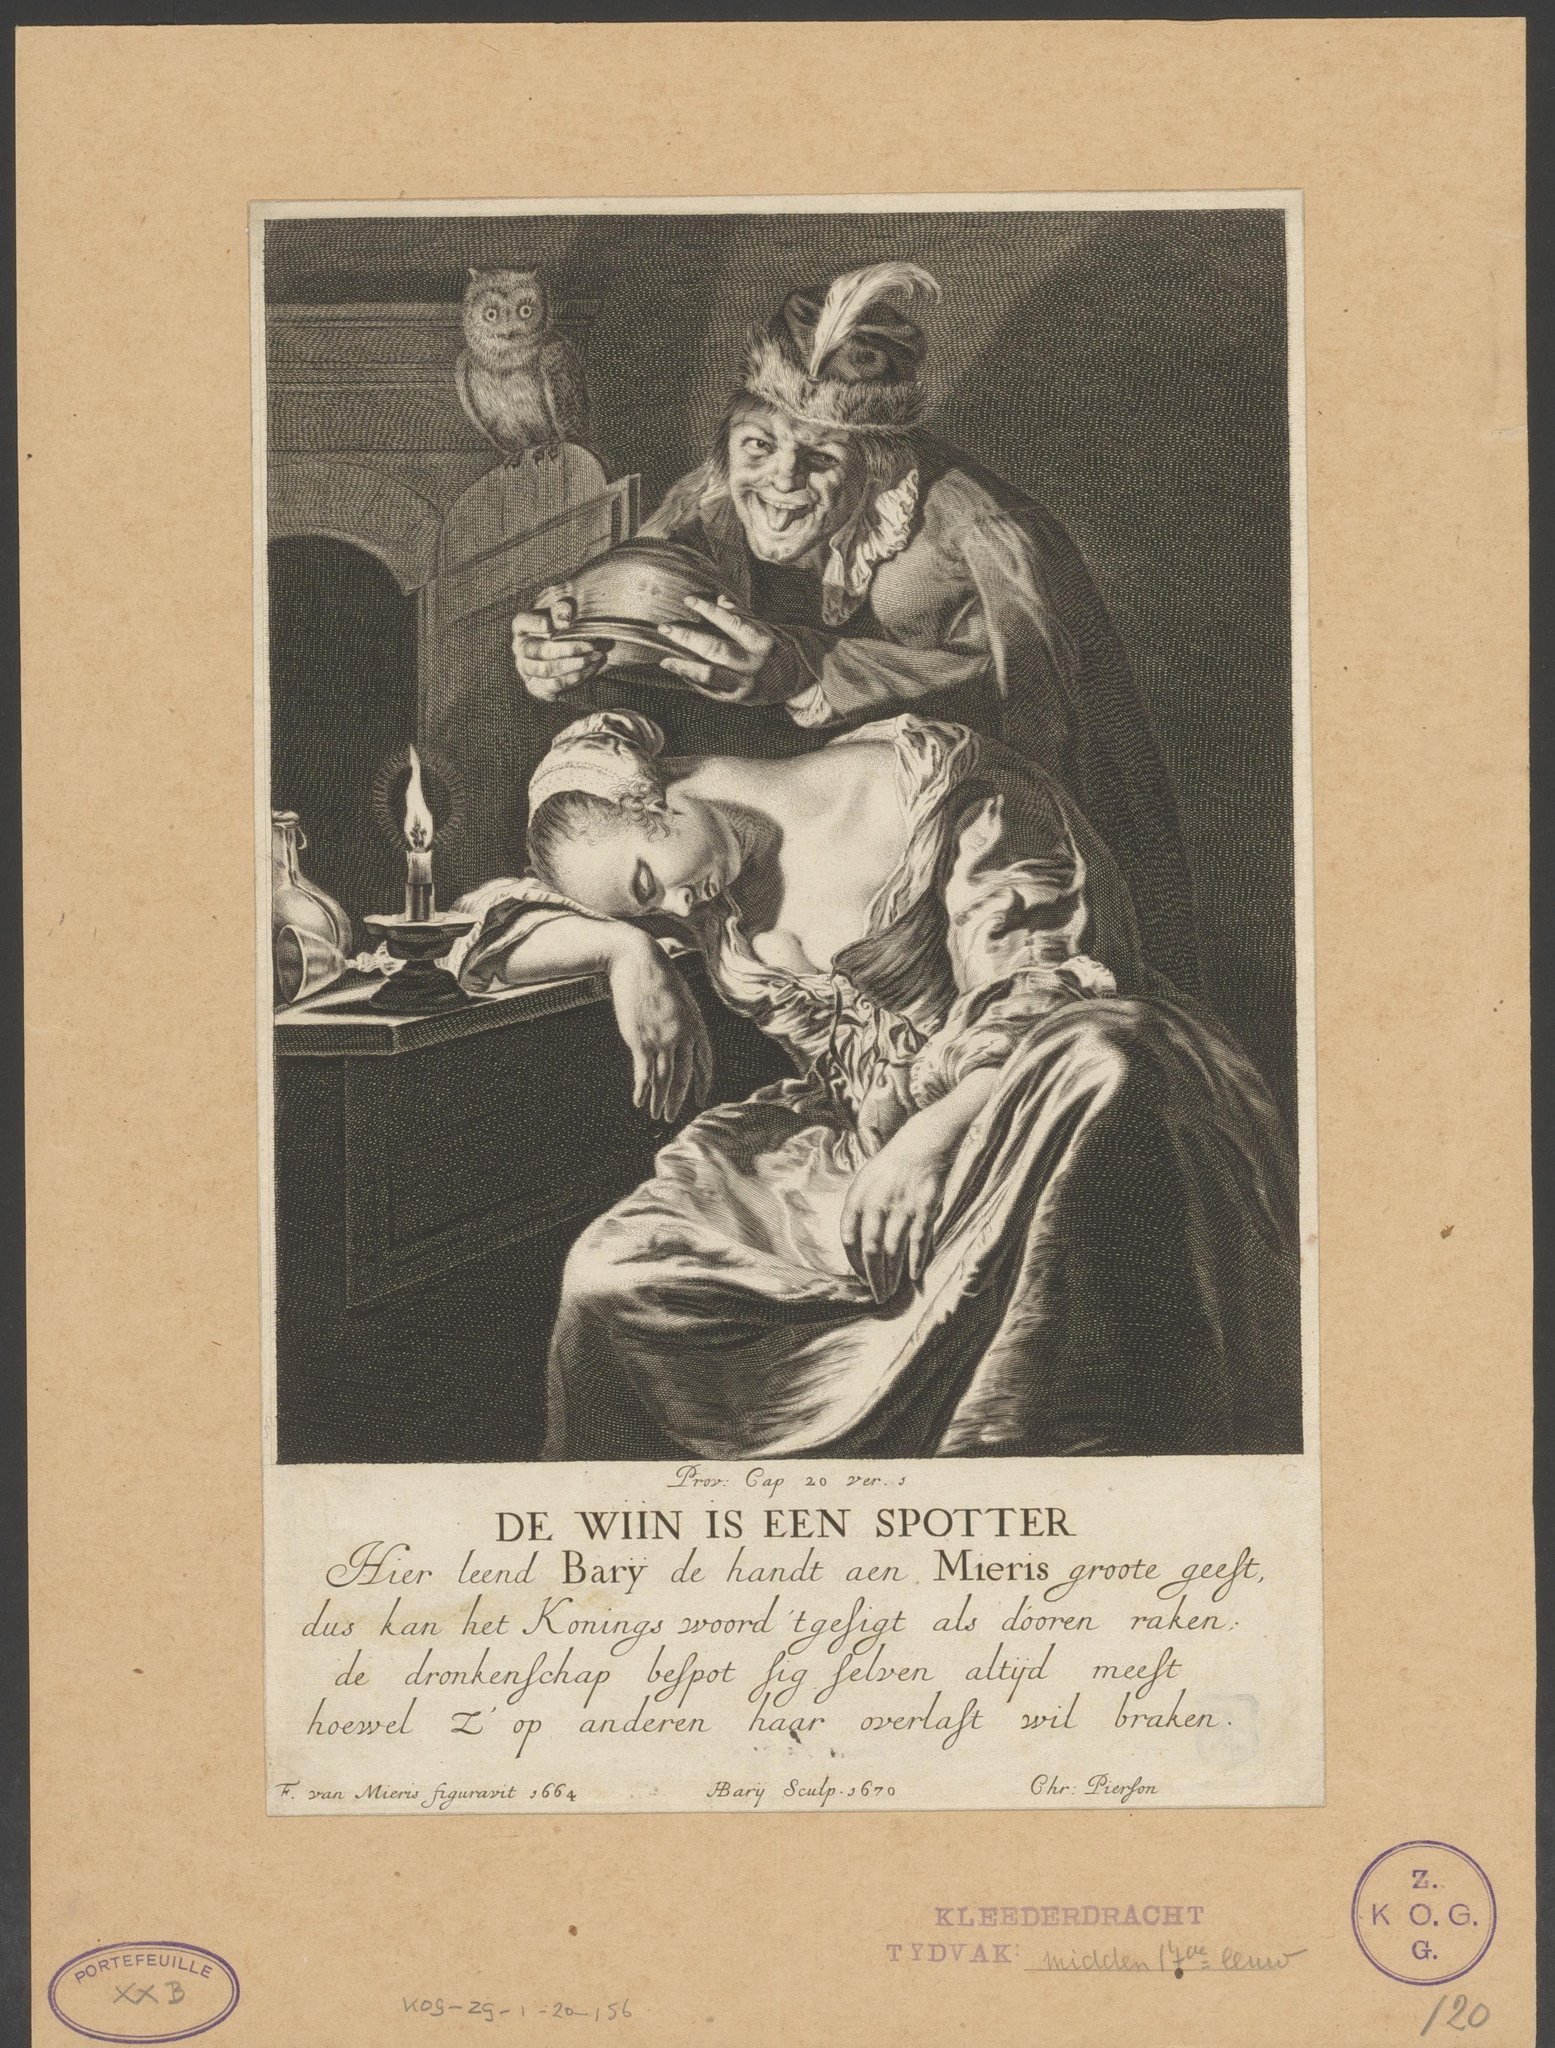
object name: print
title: De wiin is een spotter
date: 1670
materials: paper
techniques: engraving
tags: sleeping in chair, wine production, chamber-pot, 'wine is a mocker ...' ~ drunken brawl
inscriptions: collector's mark: Lugt 963, check stamp: Lugt 1120, collector's mark: Lugt 1641, stamp:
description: Een nar-achtige figuur staat op het punt om een slapende vrouw een pispot op het hoofd te zetten. Onder de voorstelling een vers van vier regels in het Nederlands. Onderwerpsrubrieken binnen de Atlas Zeden en Gewoonten: Zeden en Gewoonten in Engeren Zin, De Kleeding, Kleederdrachten (tijdvakken), Het midden der 17de eeuw. (De Fransche mode).